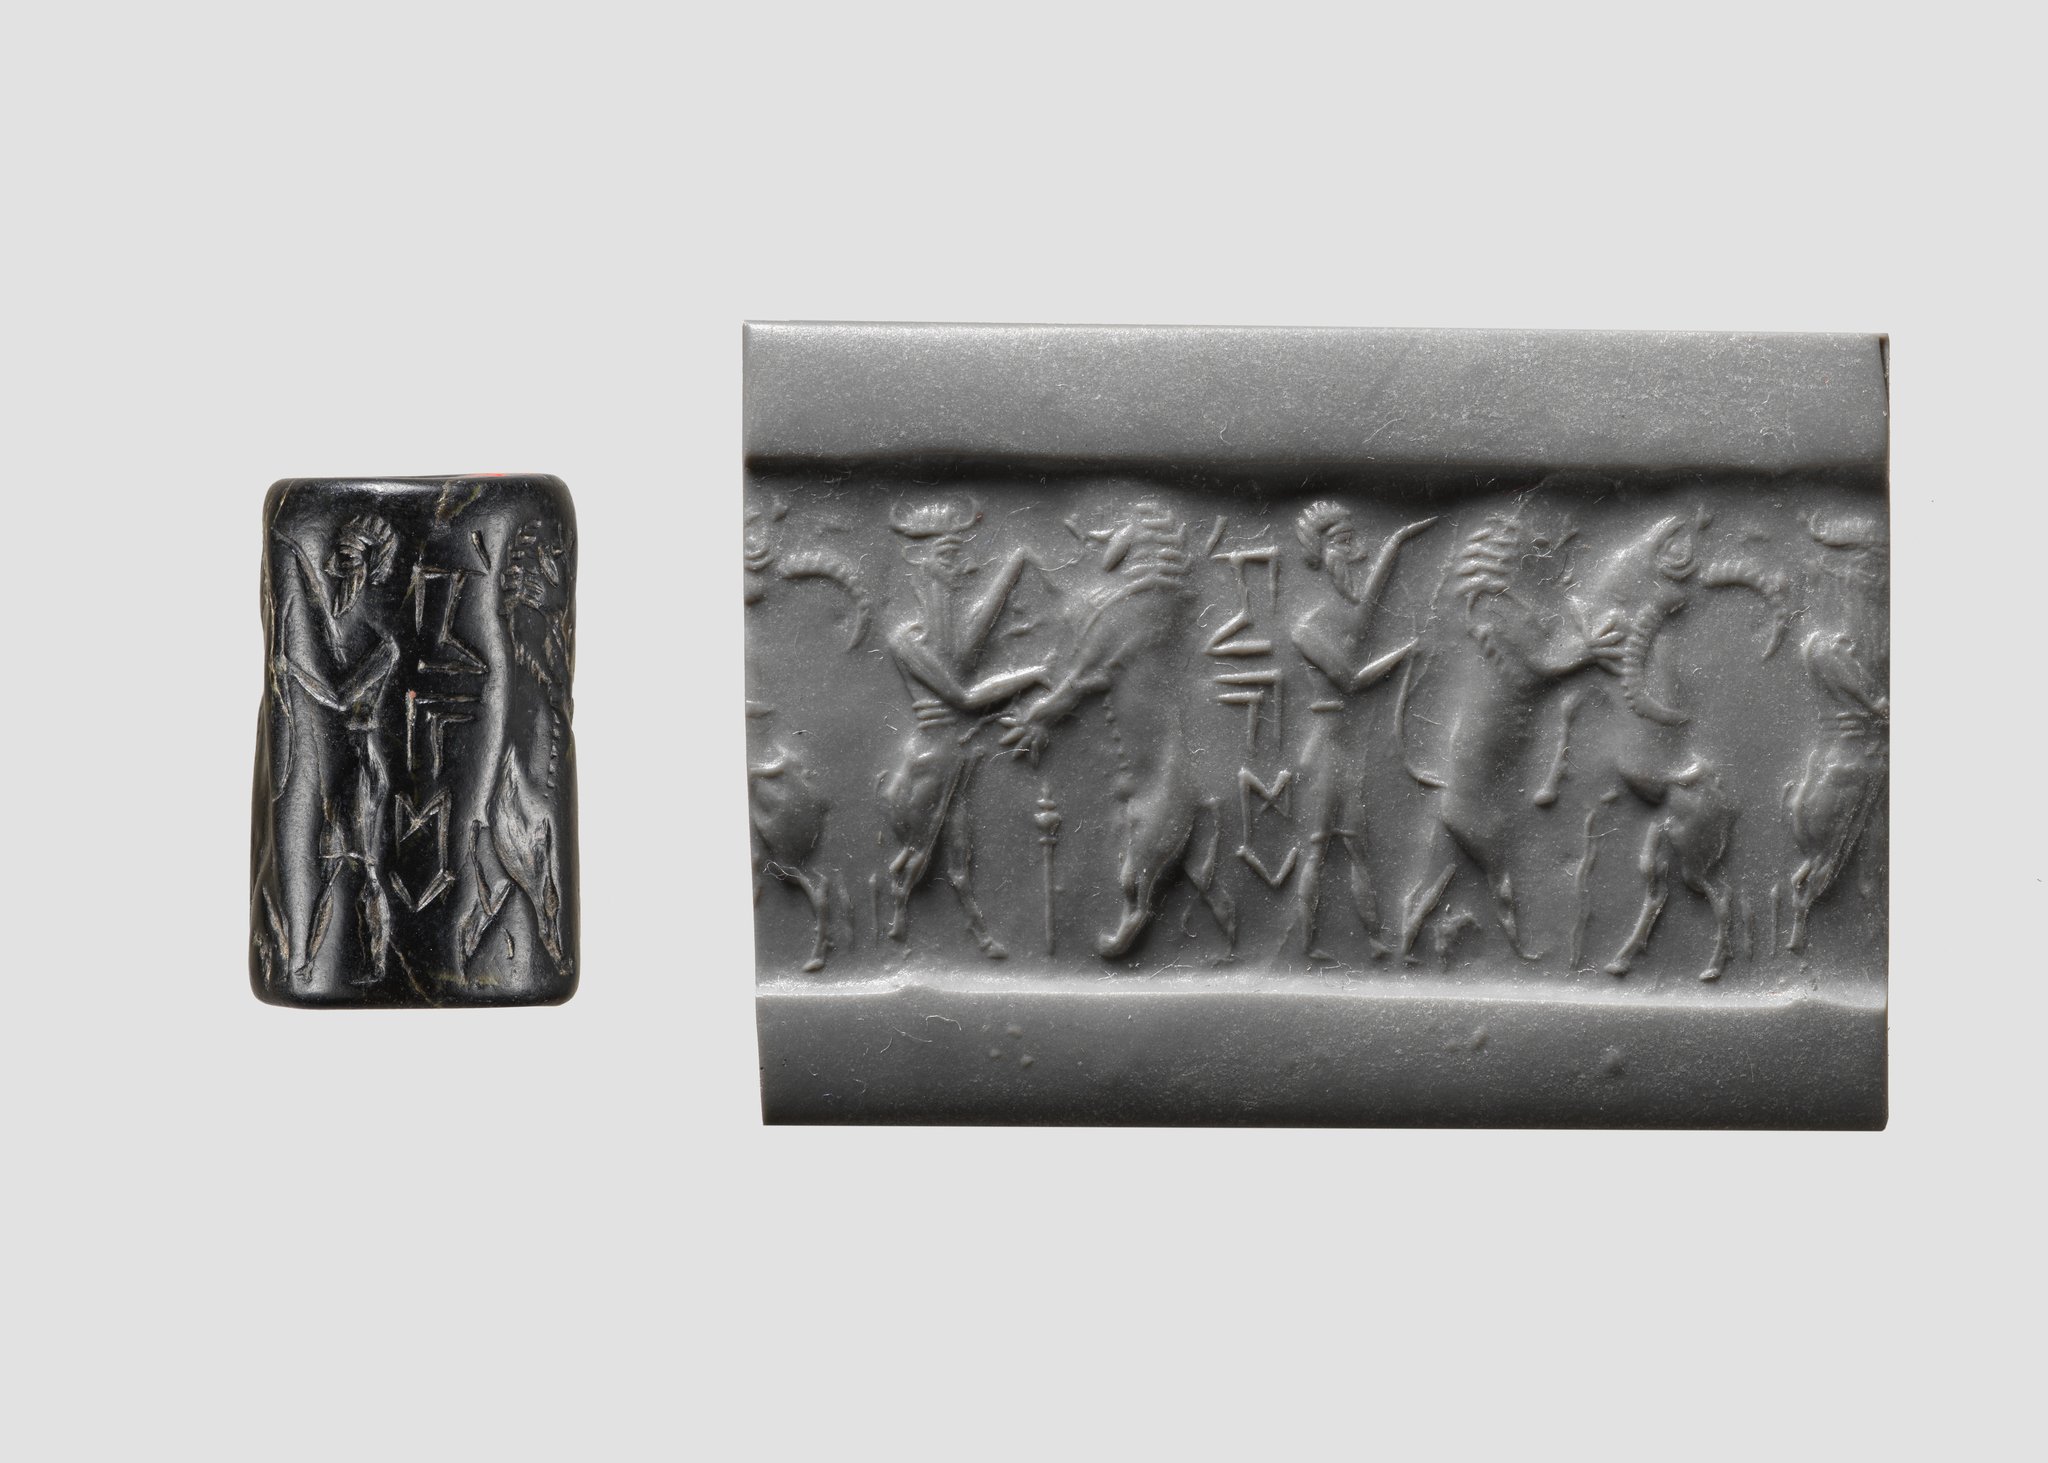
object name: cylinder seal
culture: akkadian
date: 2350-2150 BCE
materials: stone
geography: mesopotamia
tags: animals